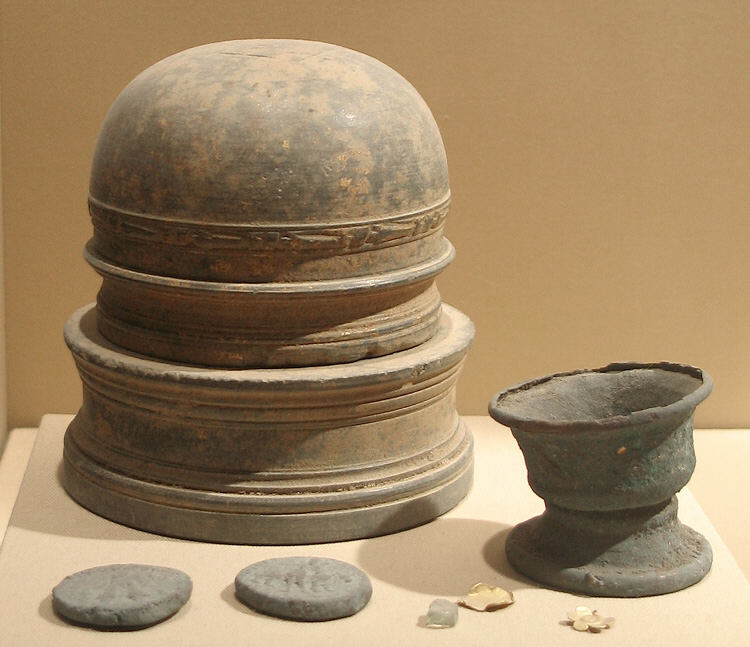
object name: reliquary with content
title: Reliquary with Contents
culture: gandhara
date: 1-300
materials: bronze, copper, crystal, gold, stone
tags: gandhara